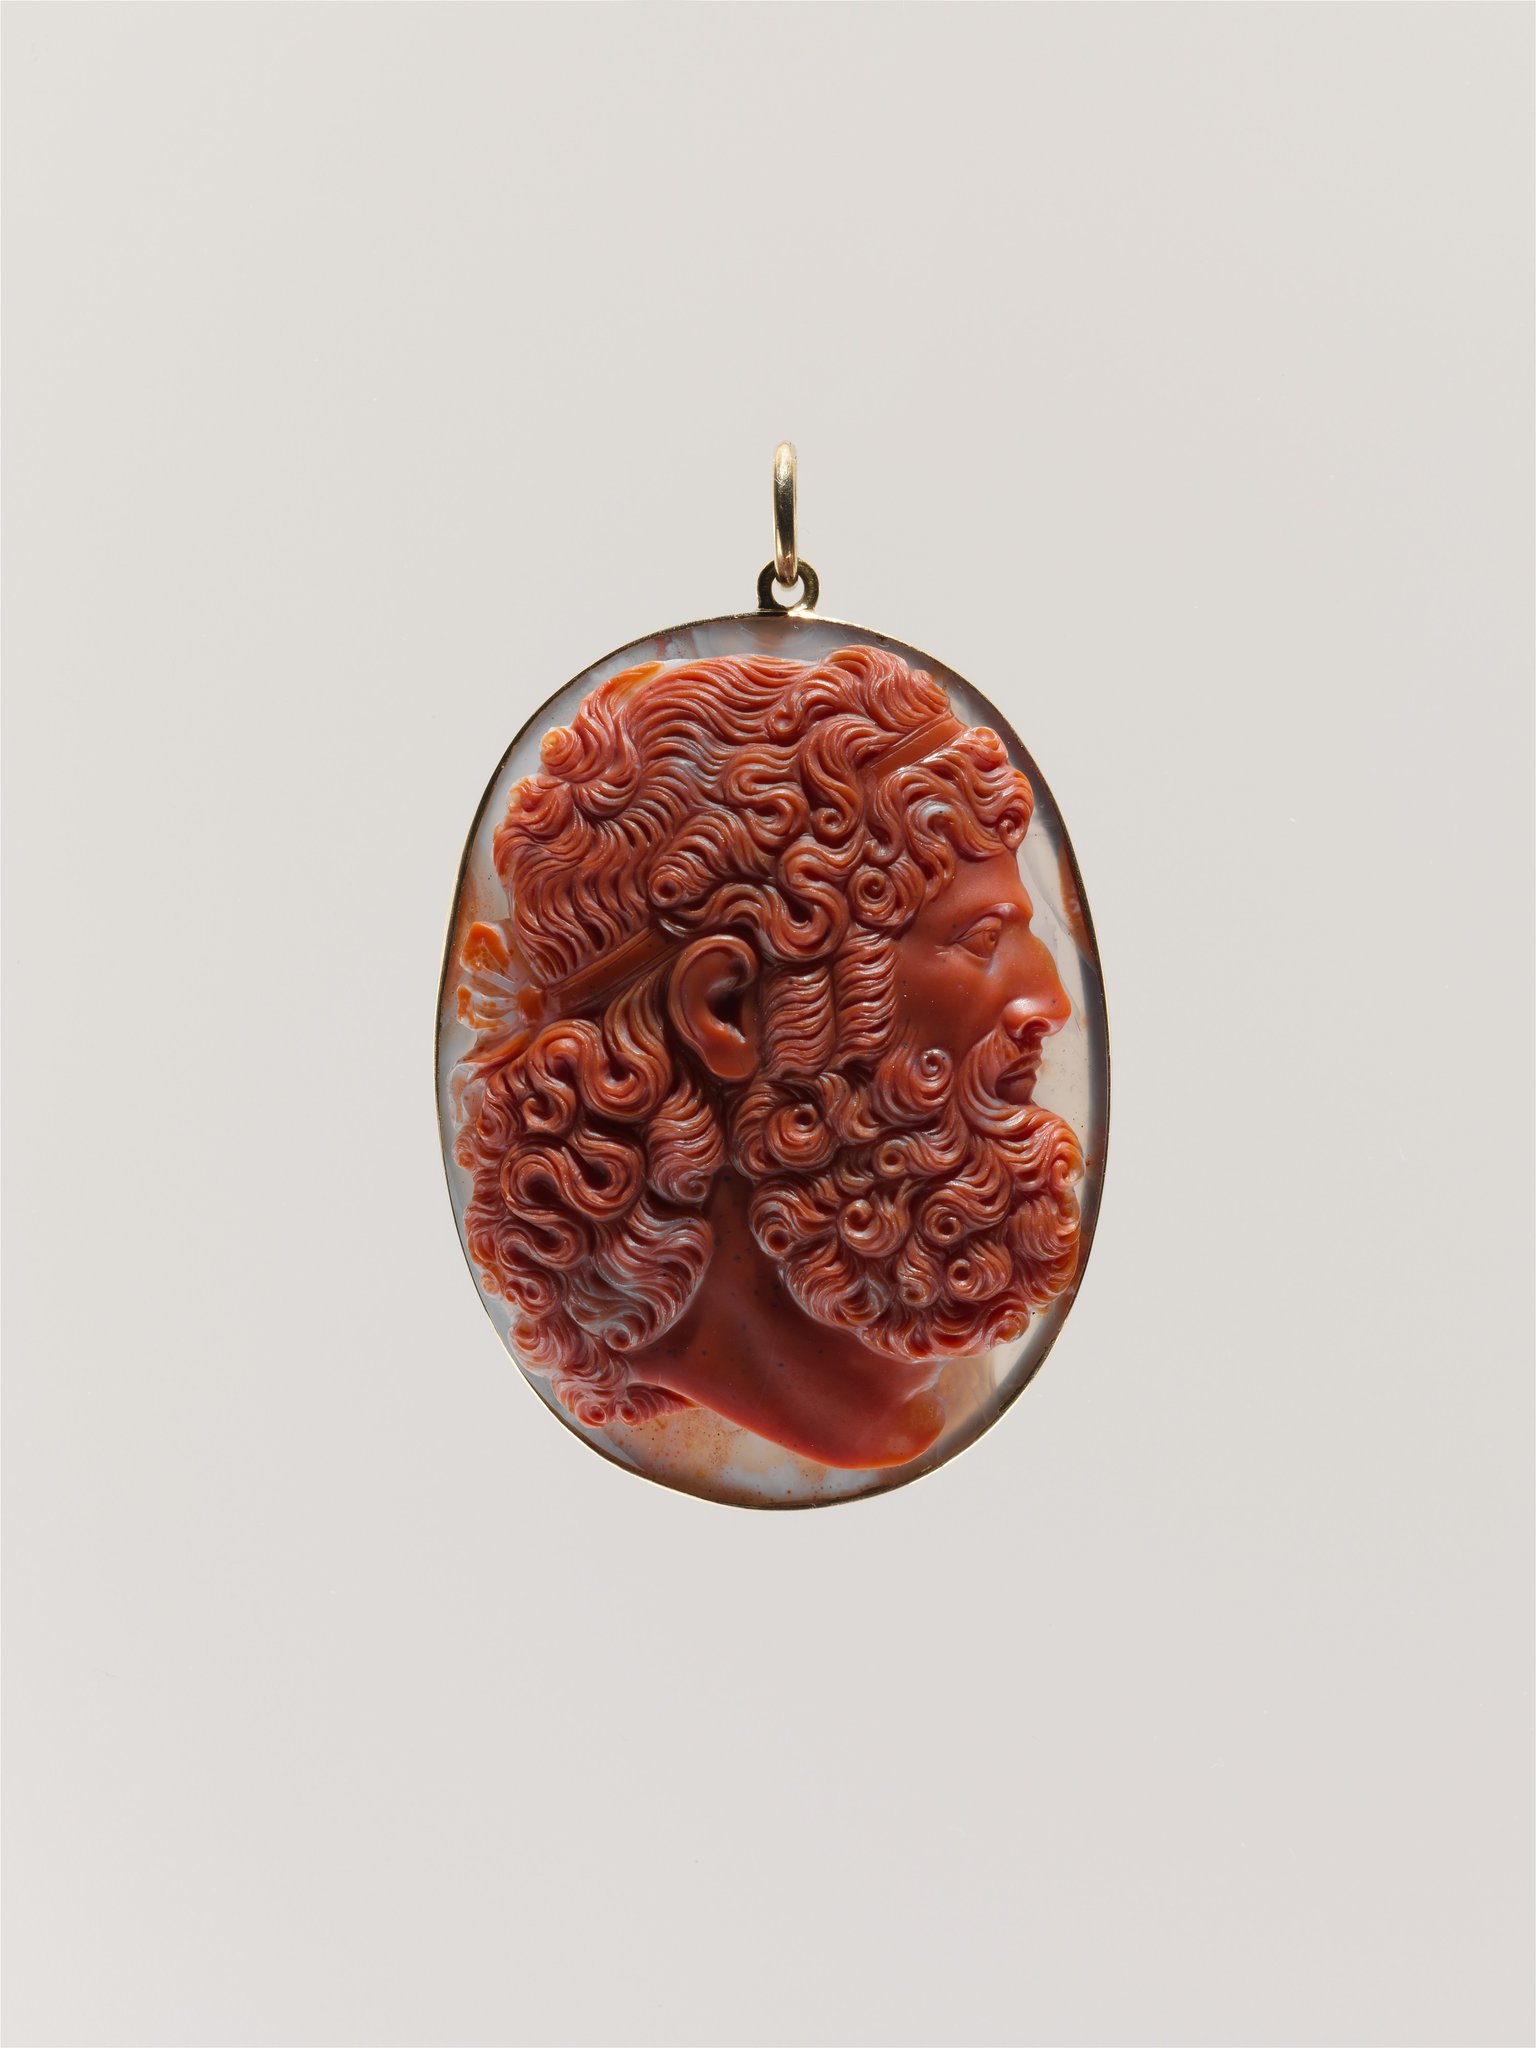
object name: cameo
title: Head of Poseidon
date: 1767-1800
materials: gold, onyx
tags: jupiter